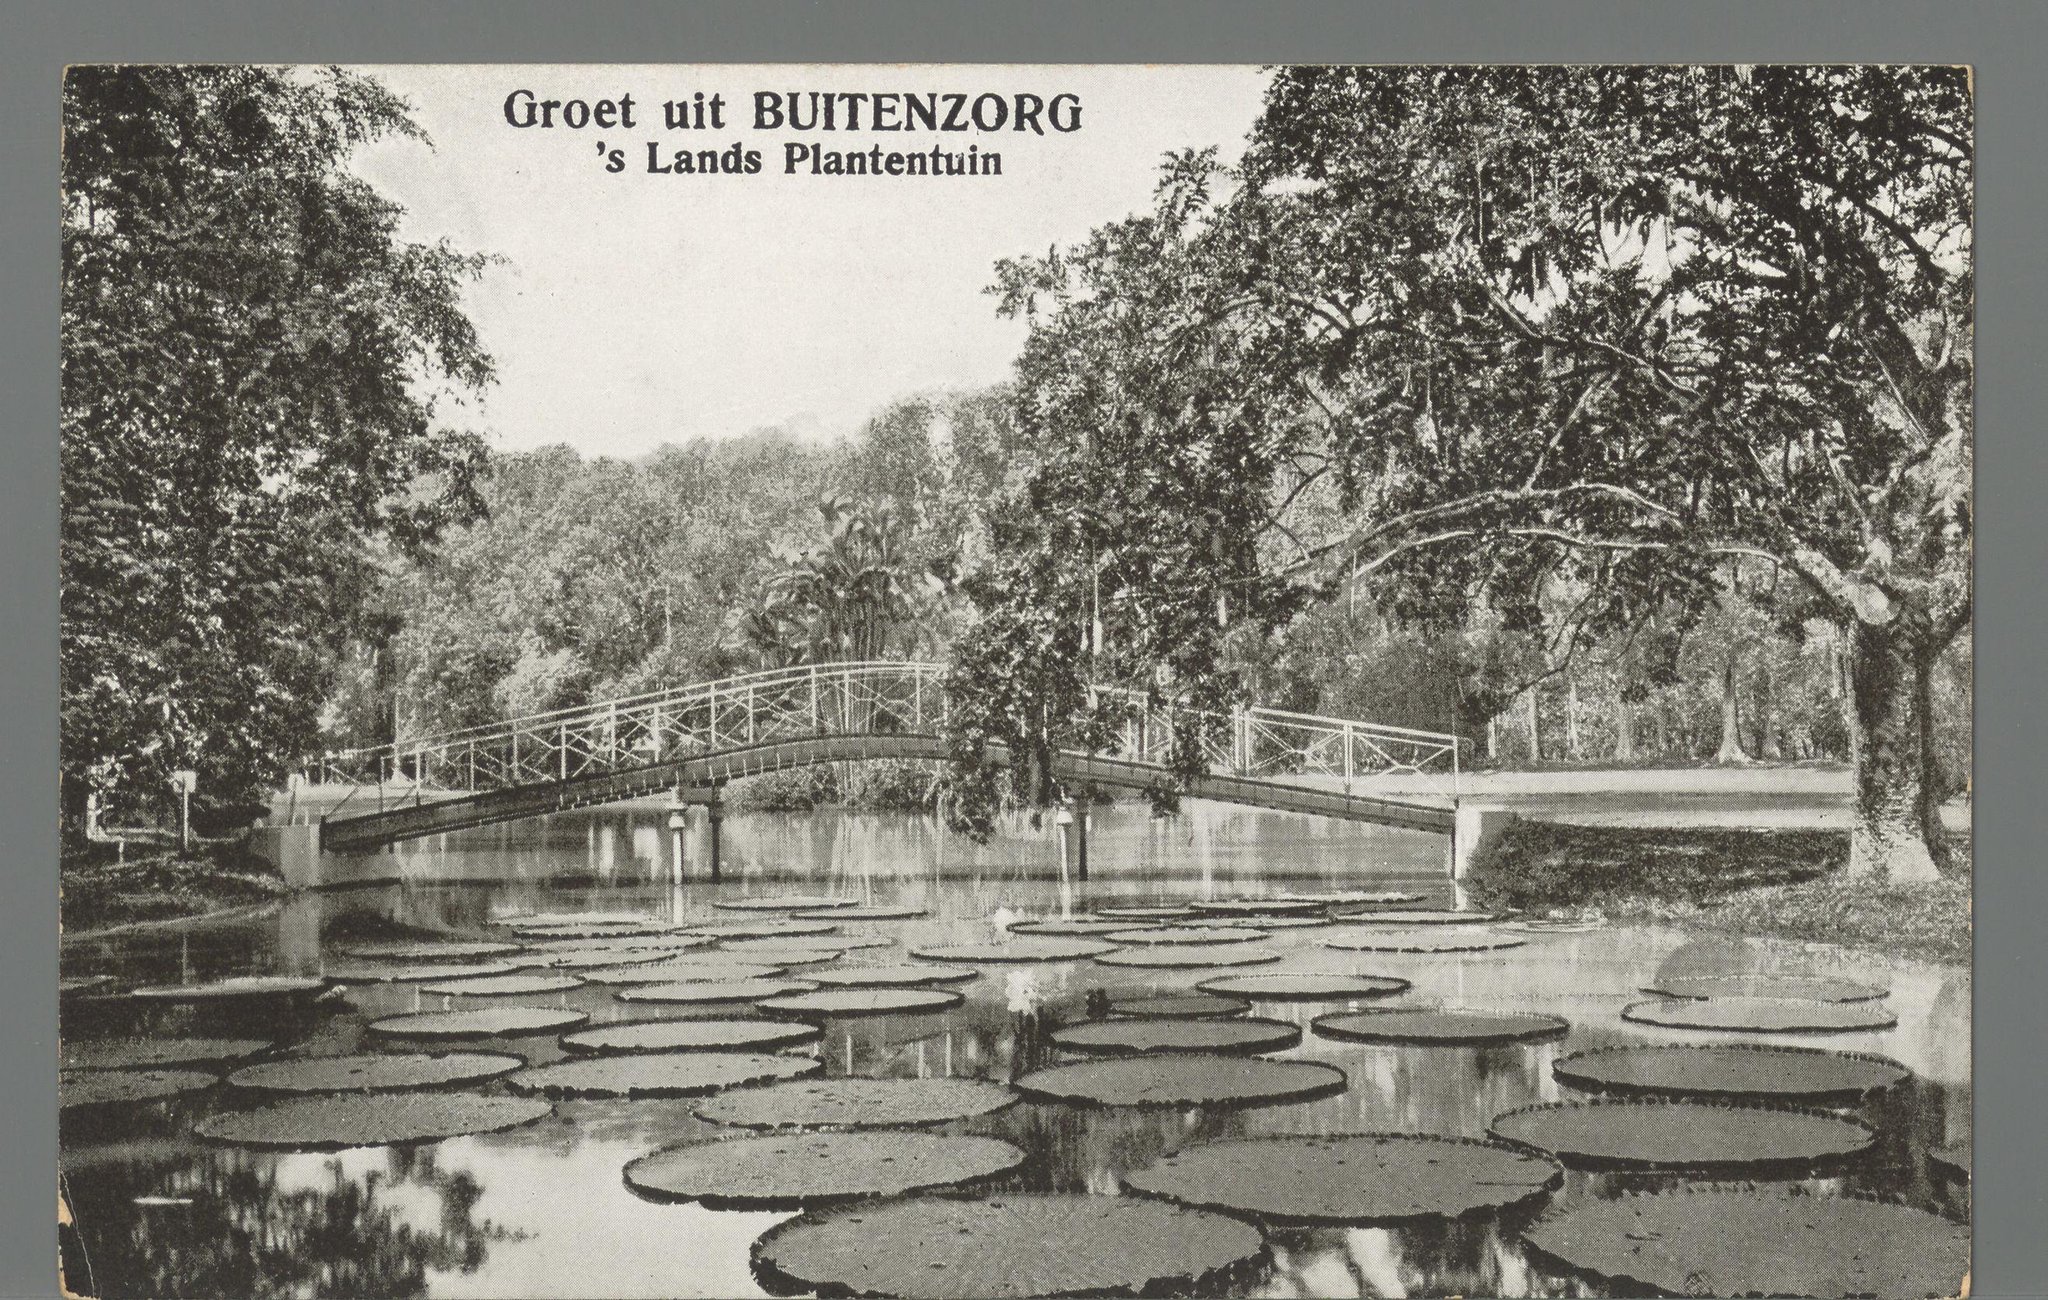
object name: ansichtkaart, prentbriefkaart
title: Groet uit Buitenzorg. 's Lands Plantentuin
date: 1906-1930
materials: cardboard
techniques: autotype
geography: weltevreden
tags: botanic garden, 'hortus botanicus', pond, bridge